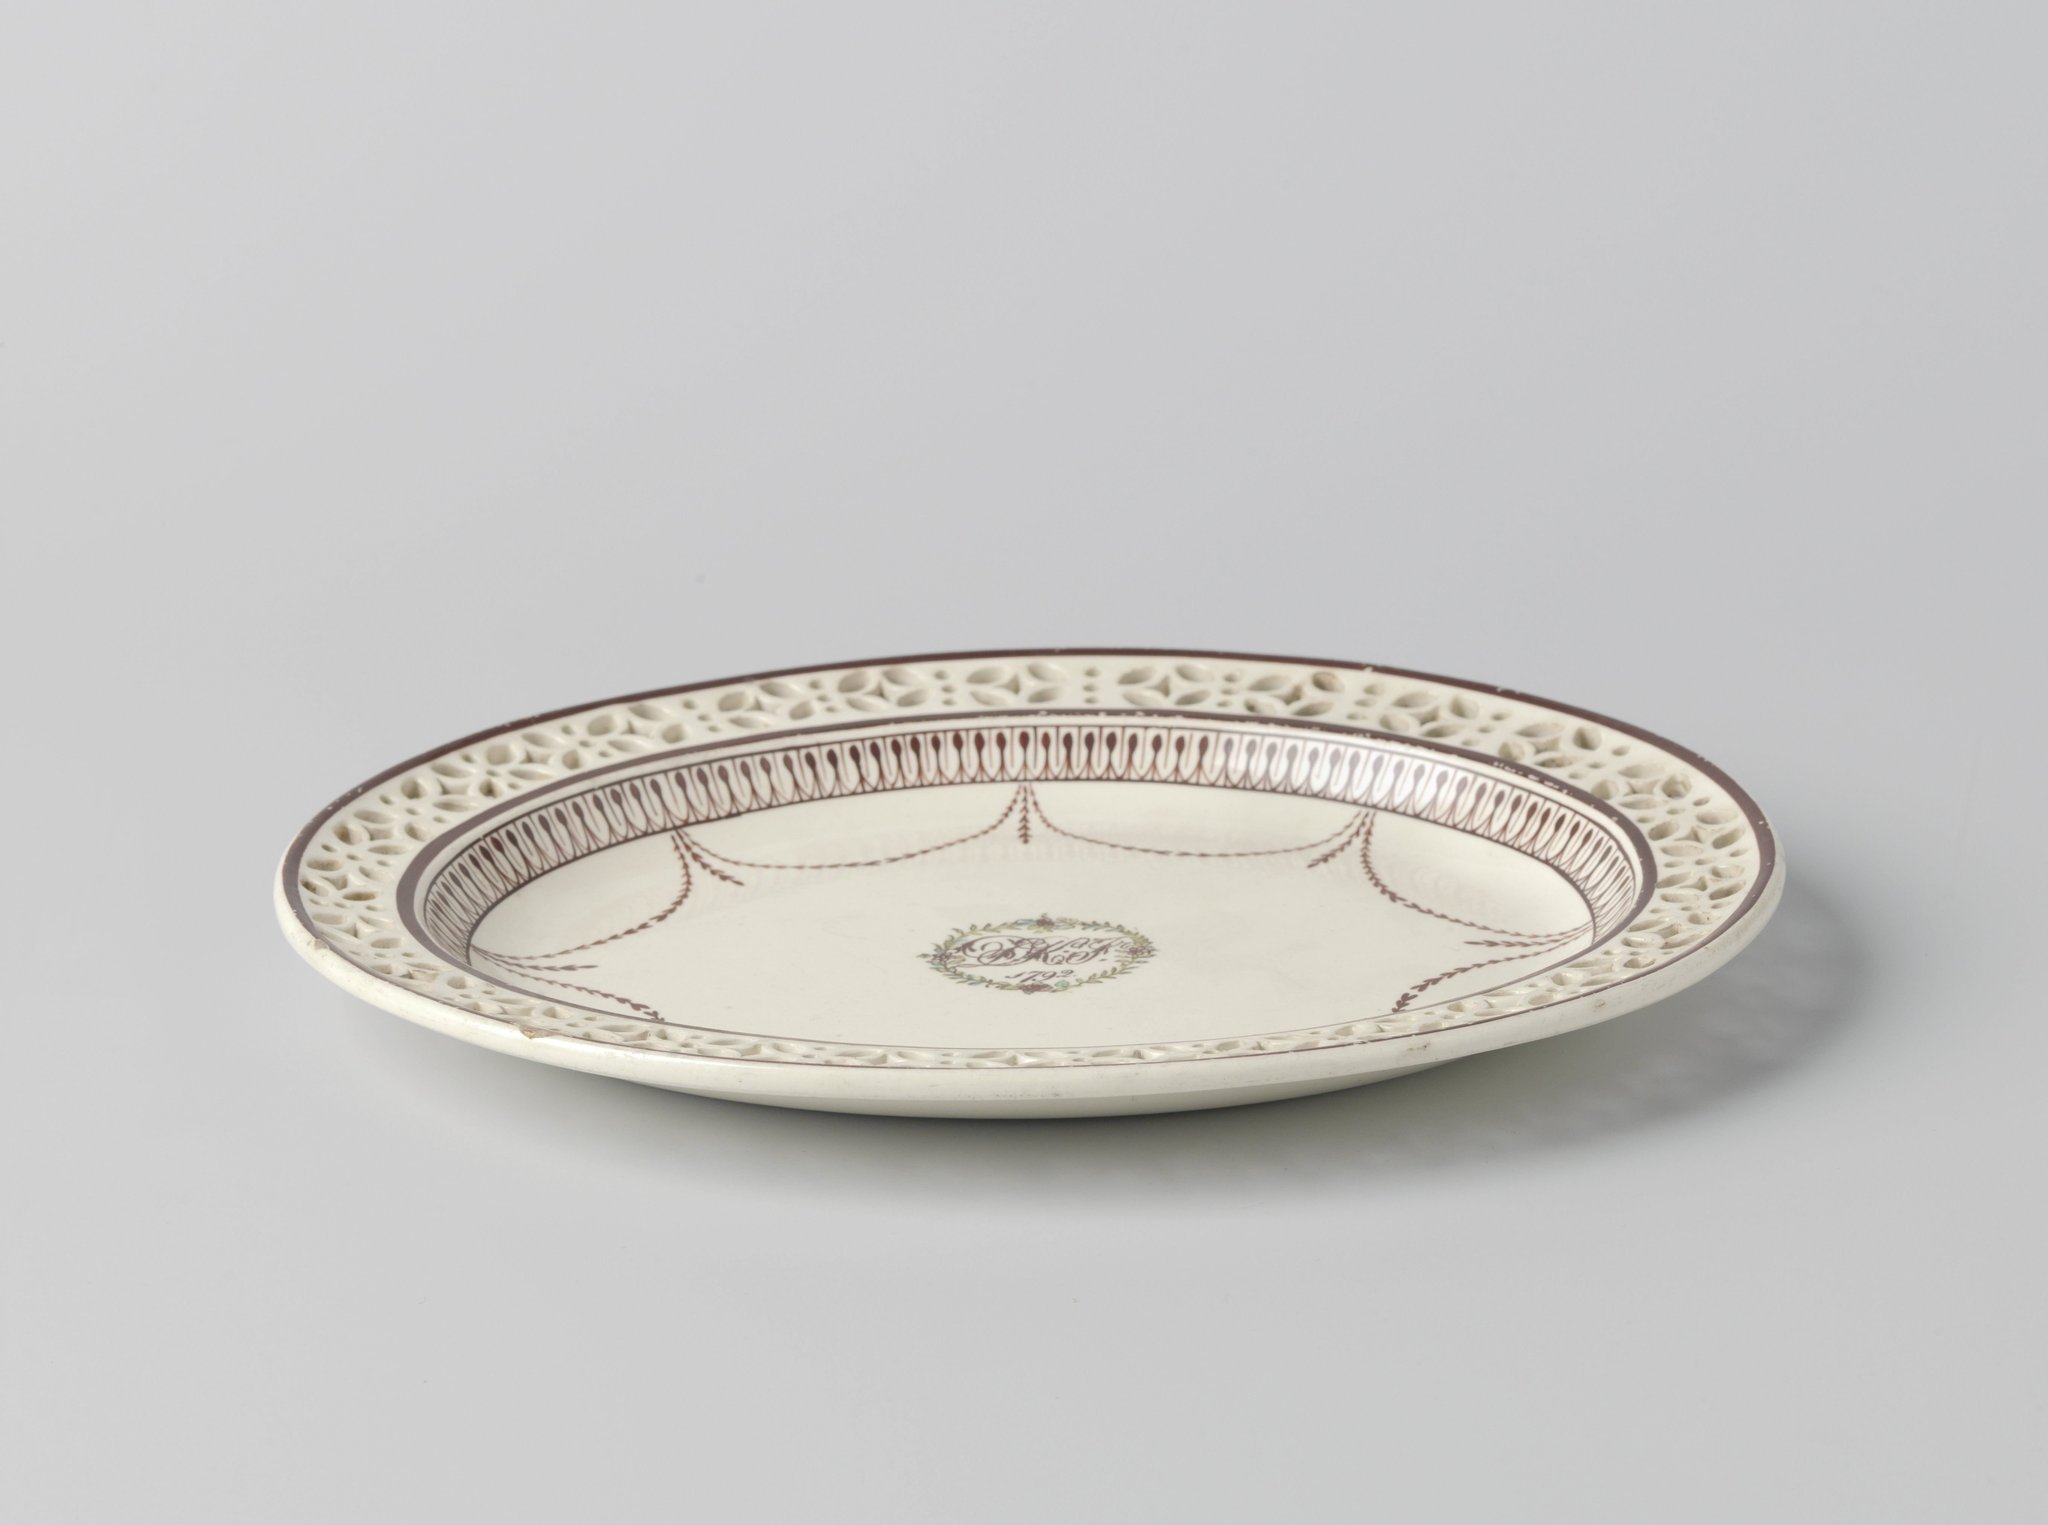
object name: platter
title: Ovale schotel van hardgebakken aardewerk; creamware.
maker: Anonymous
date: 1785-1792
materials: earthenware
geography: england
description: Ovale schotel van hardgebakken aardewerk met een veelkleurige decoratie op de glazuur. Op het plat is een bloemenkrans geschilderd waarbinnen het monogram D.S.K.Jr.1792. Vanaf de rand lopen guirlandes en festoenen. De rand is opengewerkt.